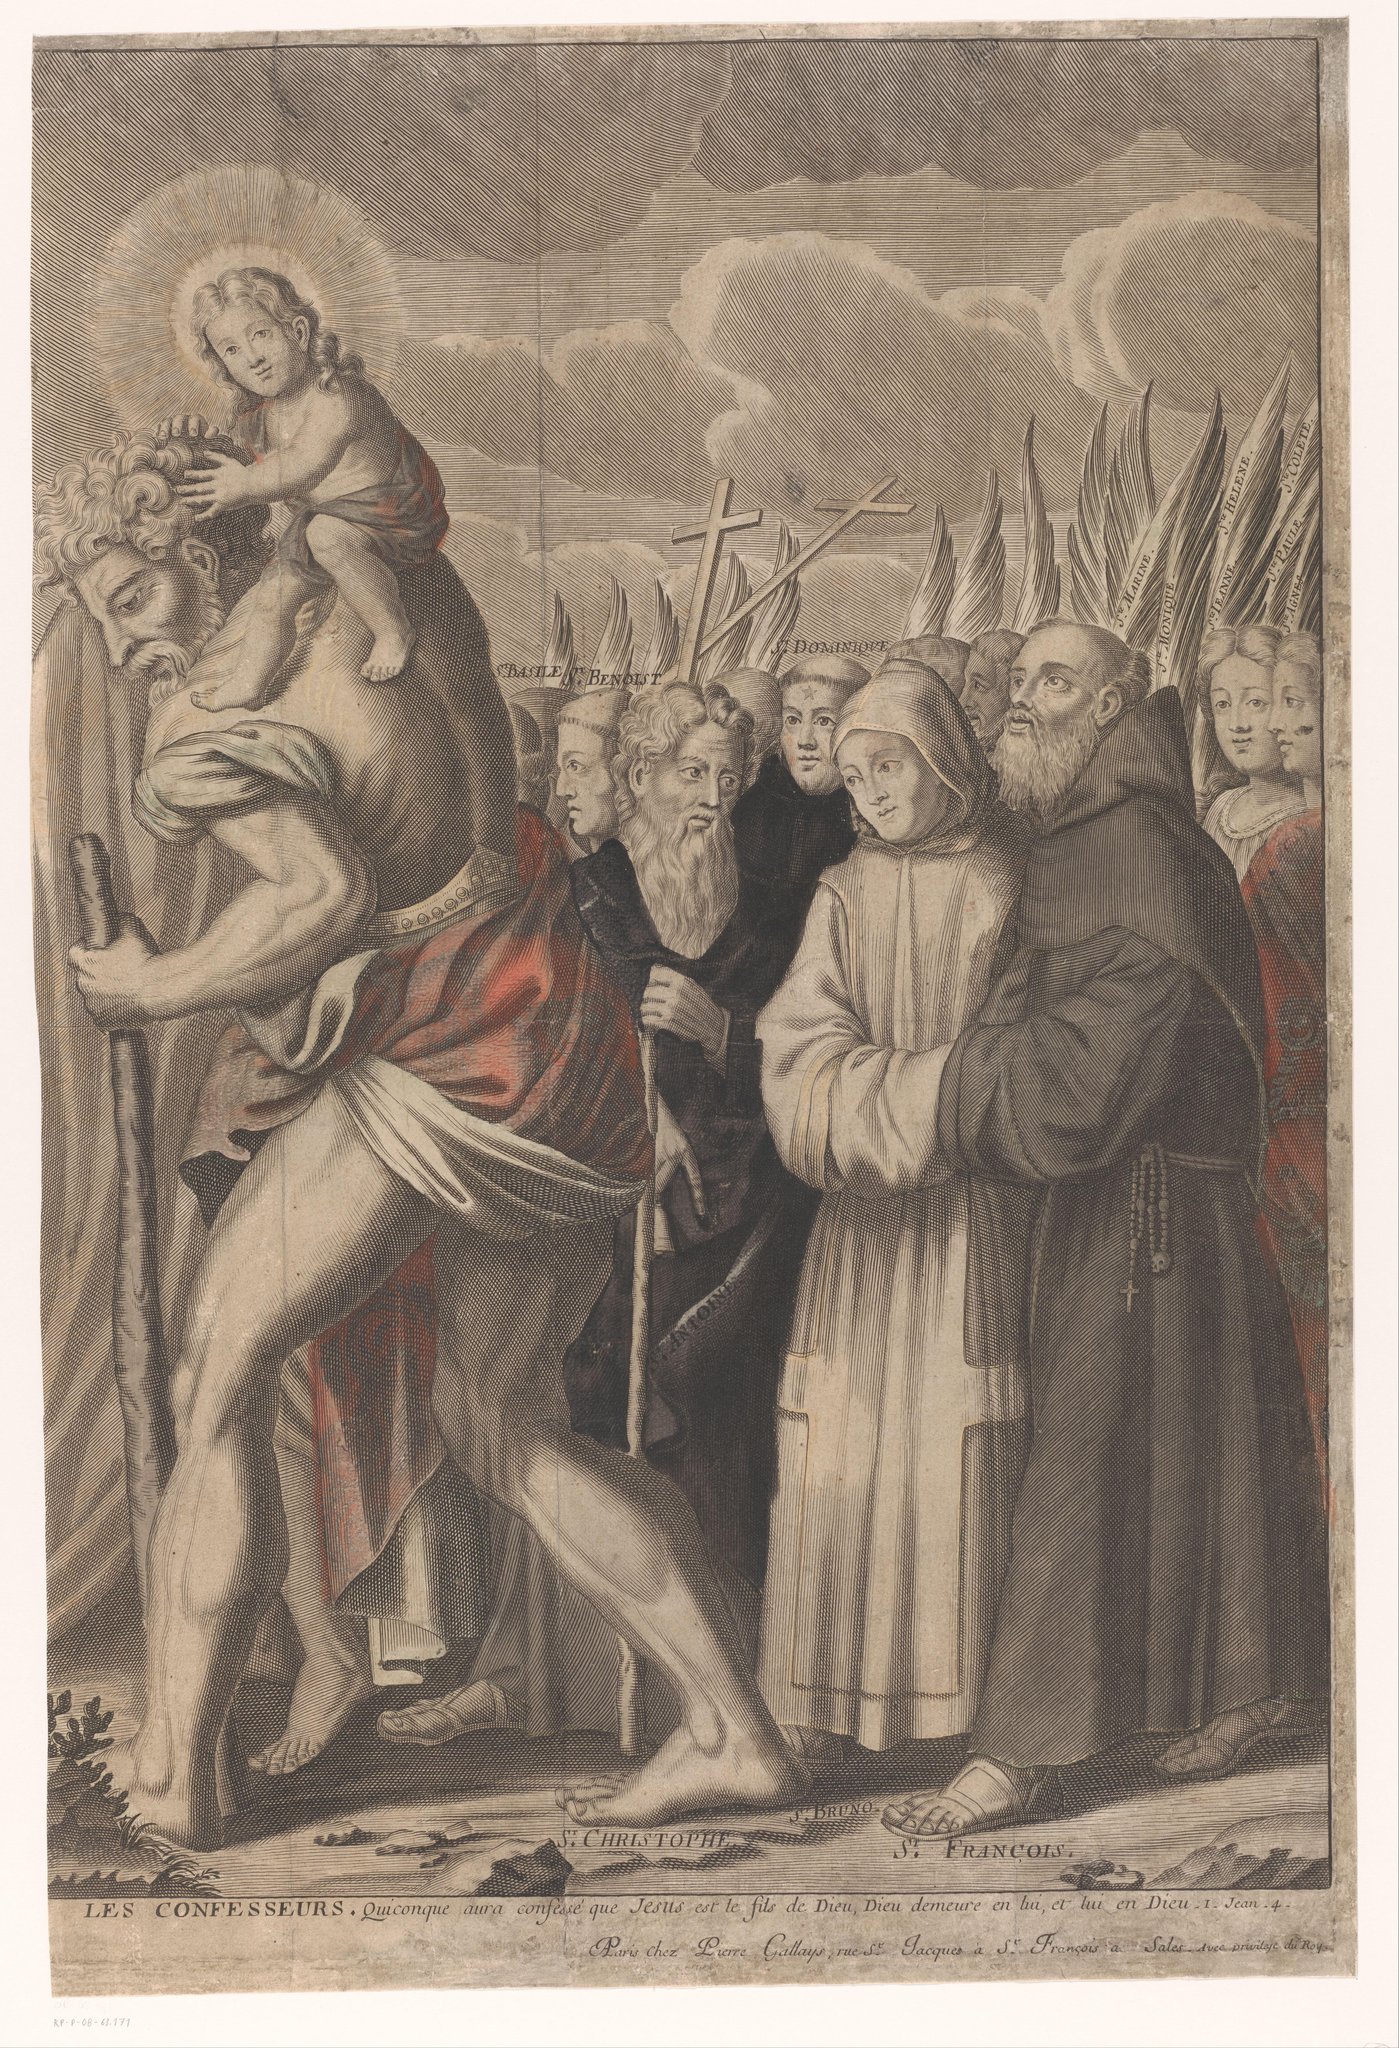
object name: print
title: Triomftocht van Christus met figuren uit het Oude en Nieuwe Testament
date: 1687-1694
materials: paper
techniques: engraving, etching, hand coloring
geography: paris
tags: the founder of the order of the carthusians, bruno; possible attributes: cross, finger at lips, lily, mitre at his feet, olive-branch, ray of light, skull, (seven) star(s), triumphs (allegorical and symbolic), founder of the order of friars minor (franciscans), francis(cus) of assisi; possible attributes: book, crucifix, lily, skull, stigmata, the giant and martyr christophorus; possible attributes: palm-tree (with bunches of dates, or withered), infant christ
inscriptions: collector's mark: Lugt 2228